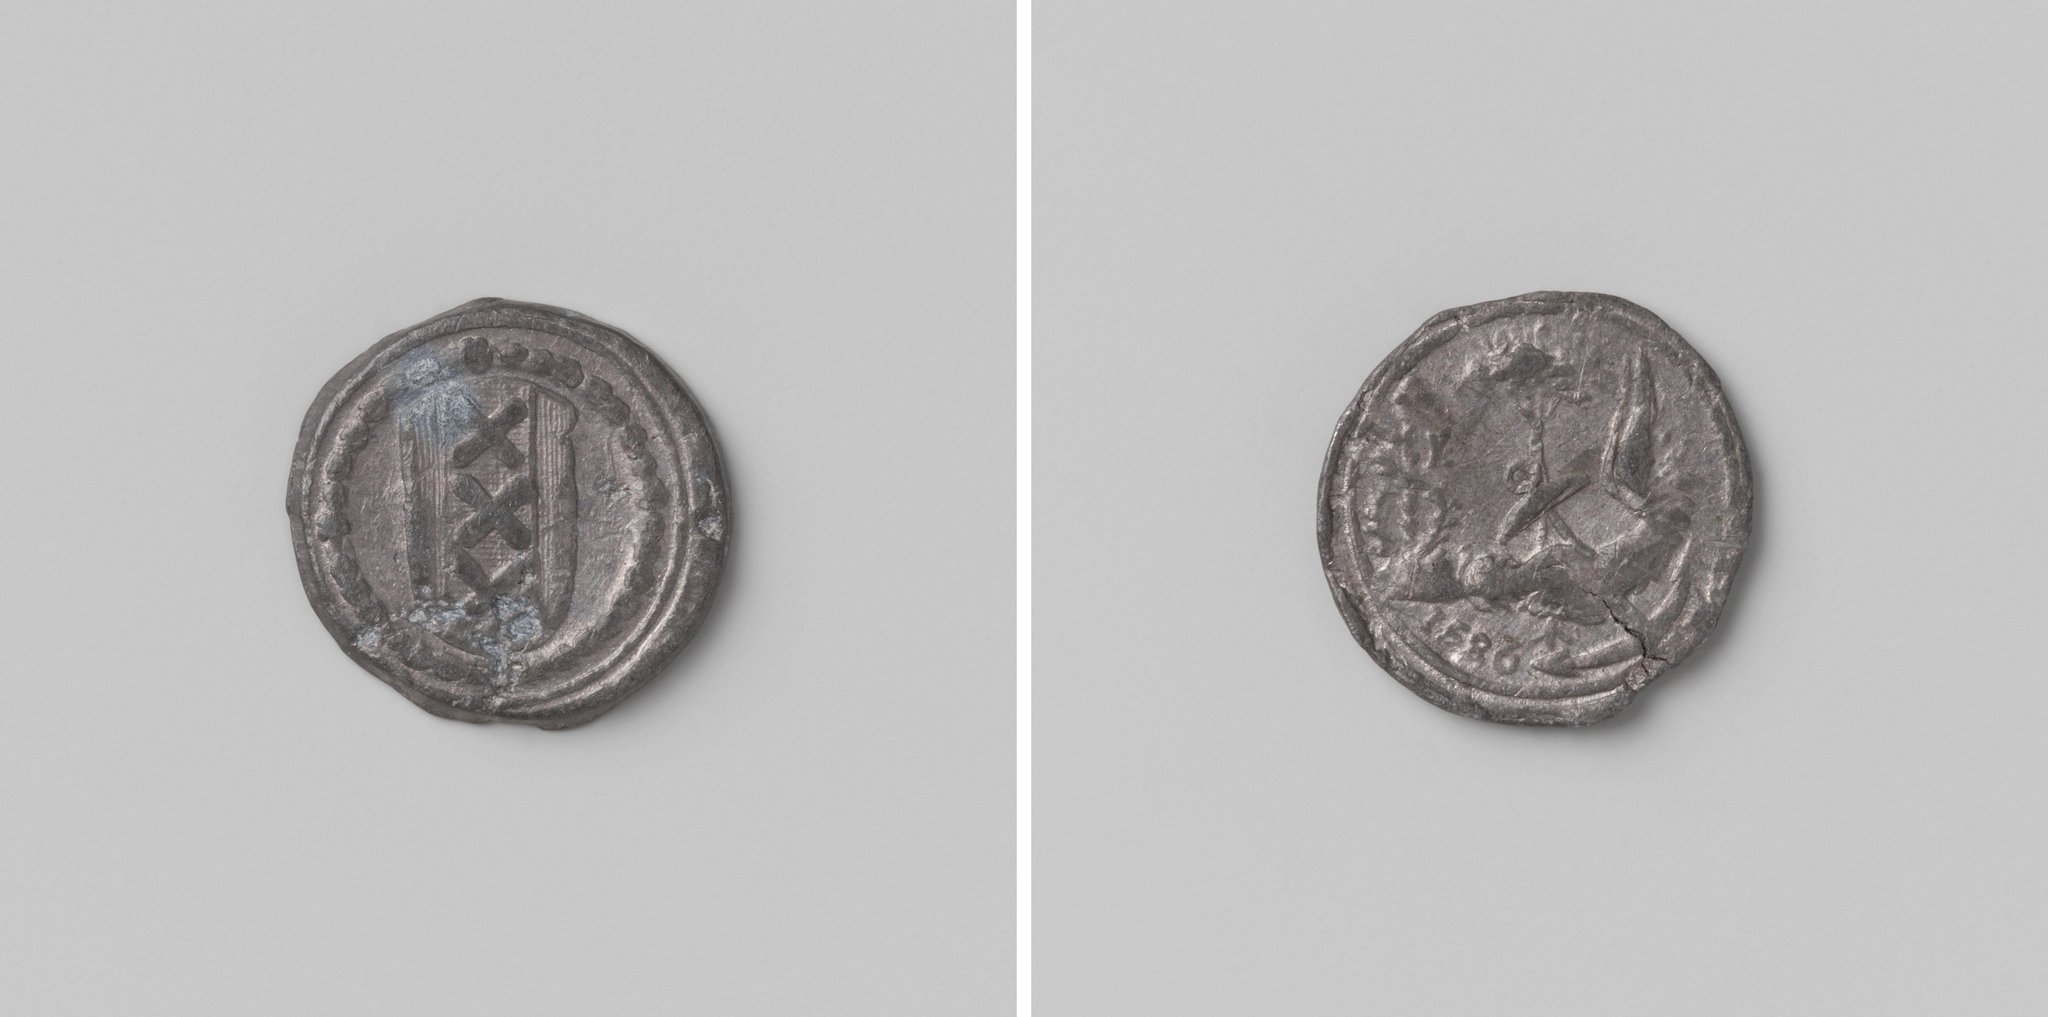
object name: armenloodje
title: Stad Amsterdam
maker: Anonymous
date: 1586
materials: lead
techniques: striking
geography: amsterdam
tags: amsterdam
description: Loden penning. Voorzijde: wapenschild in bladerkrans. Keerzijde: twee ineengeslagen handen uit wolken houden gezamelijk anker vast; links onder: jaartal